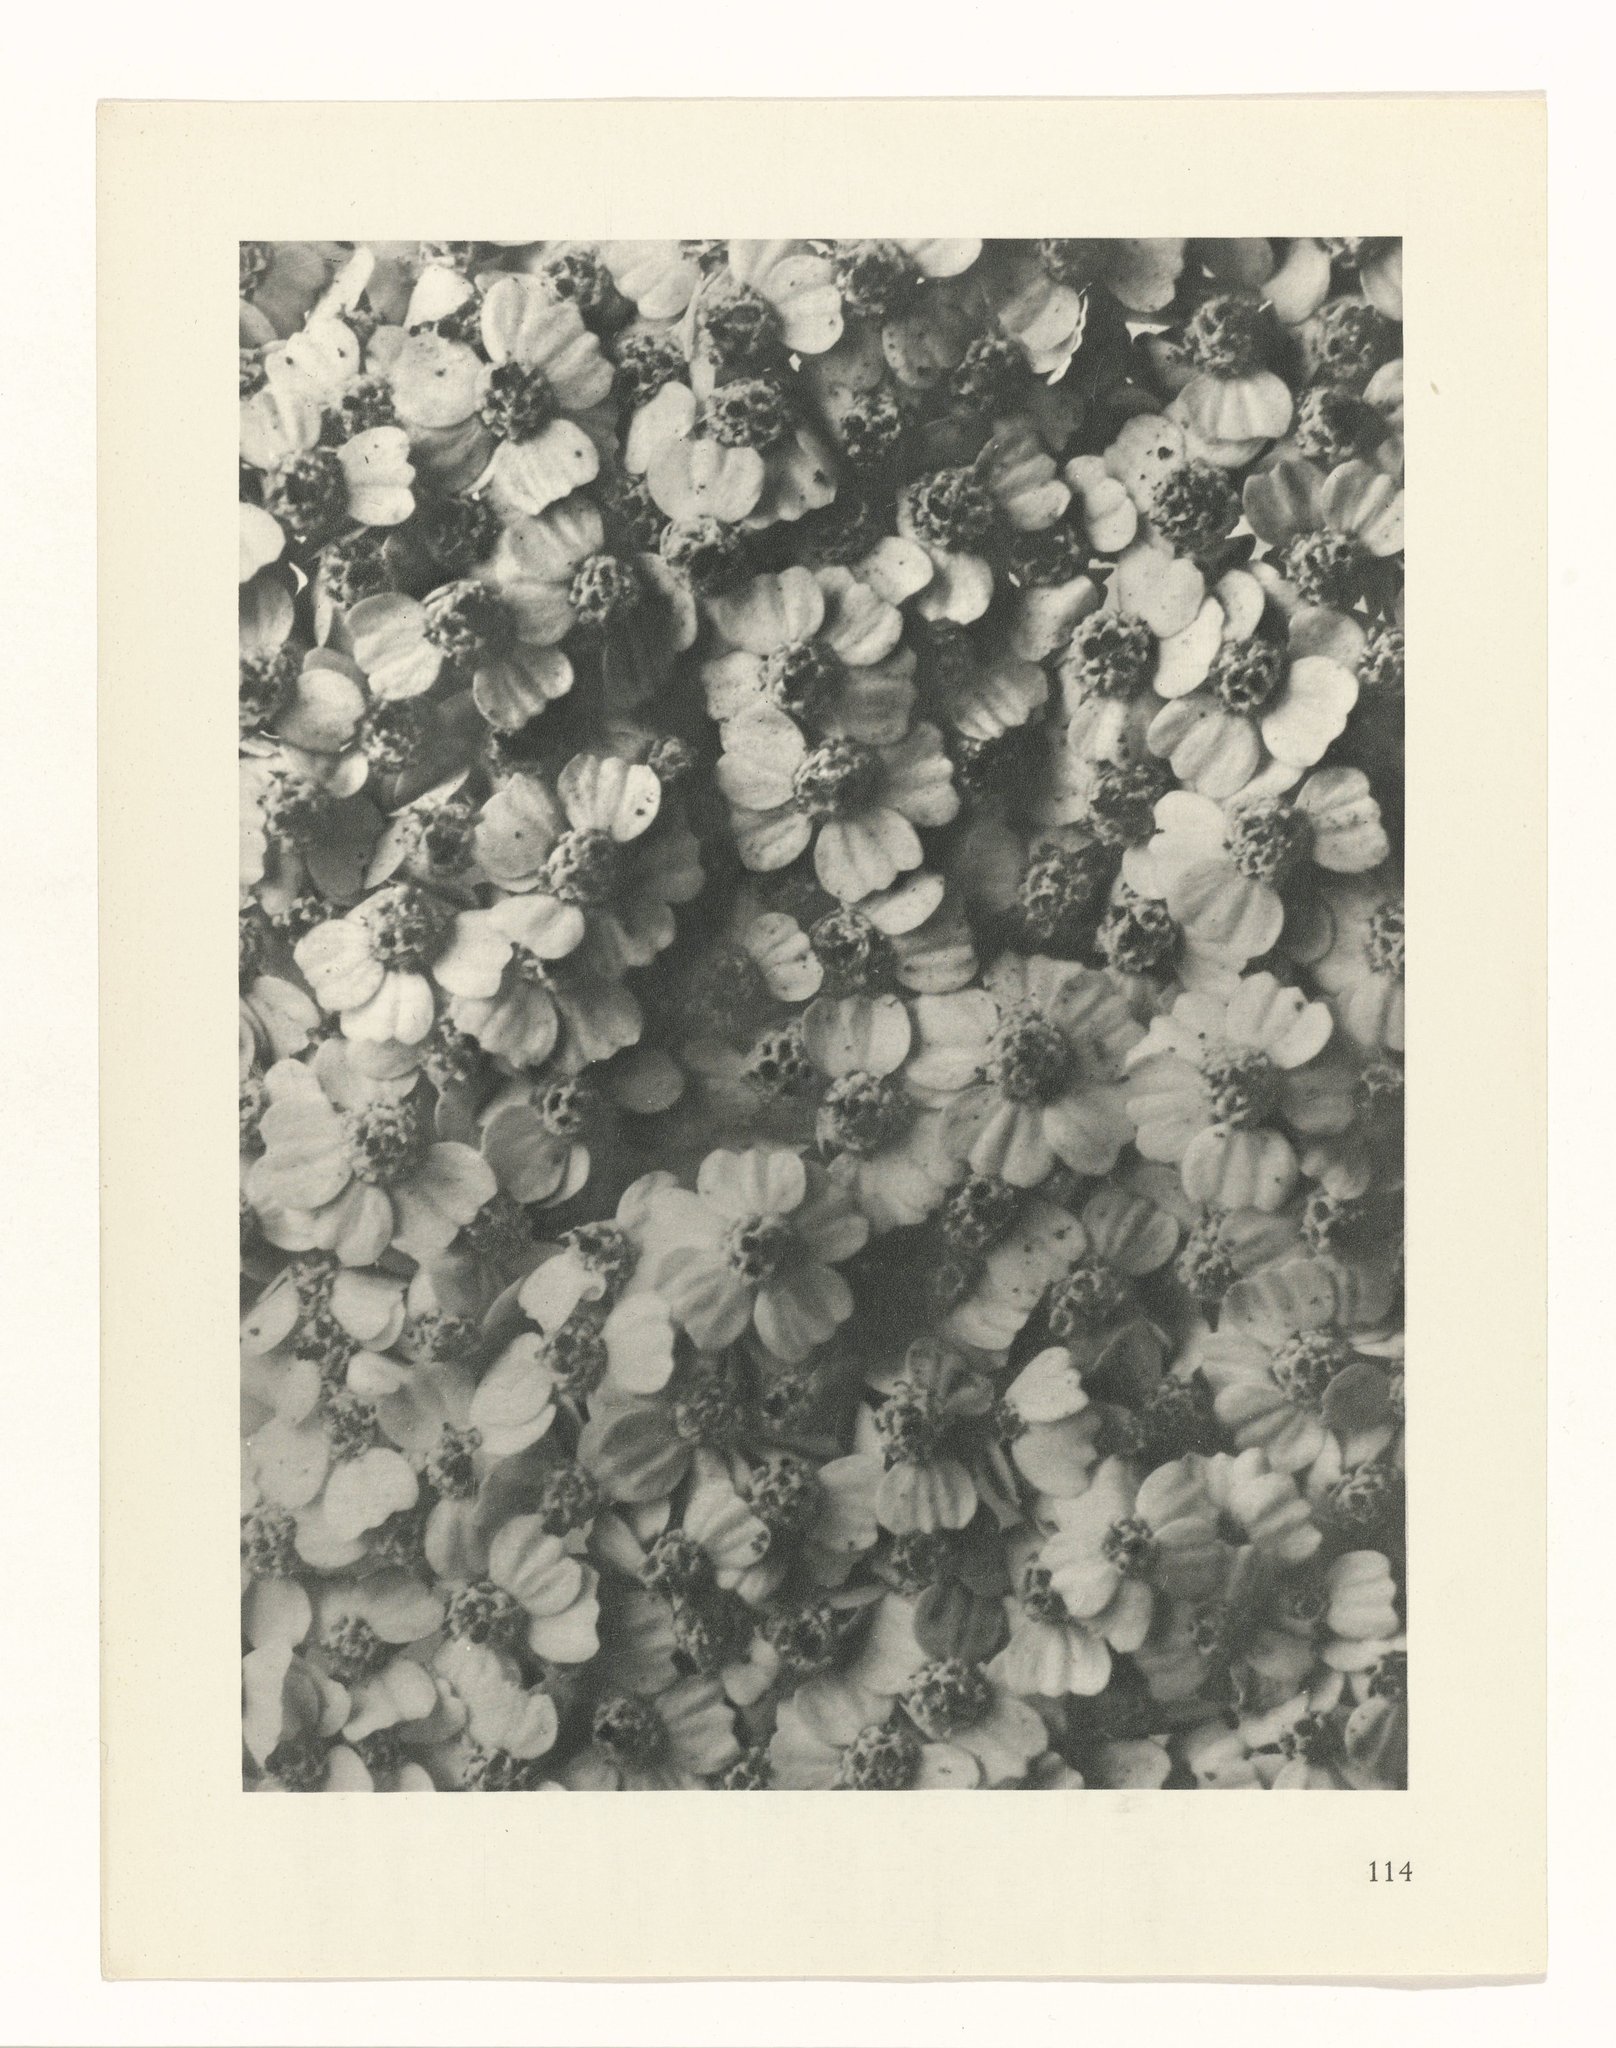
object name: photograph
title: Urformen der Kunst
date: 1928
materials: ink, paper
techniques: rotogravure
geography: berlin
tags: plants (in general)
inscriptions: number: ‘114’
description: facher Vergrößerung. Afkomstig uit losbladige uitgave.